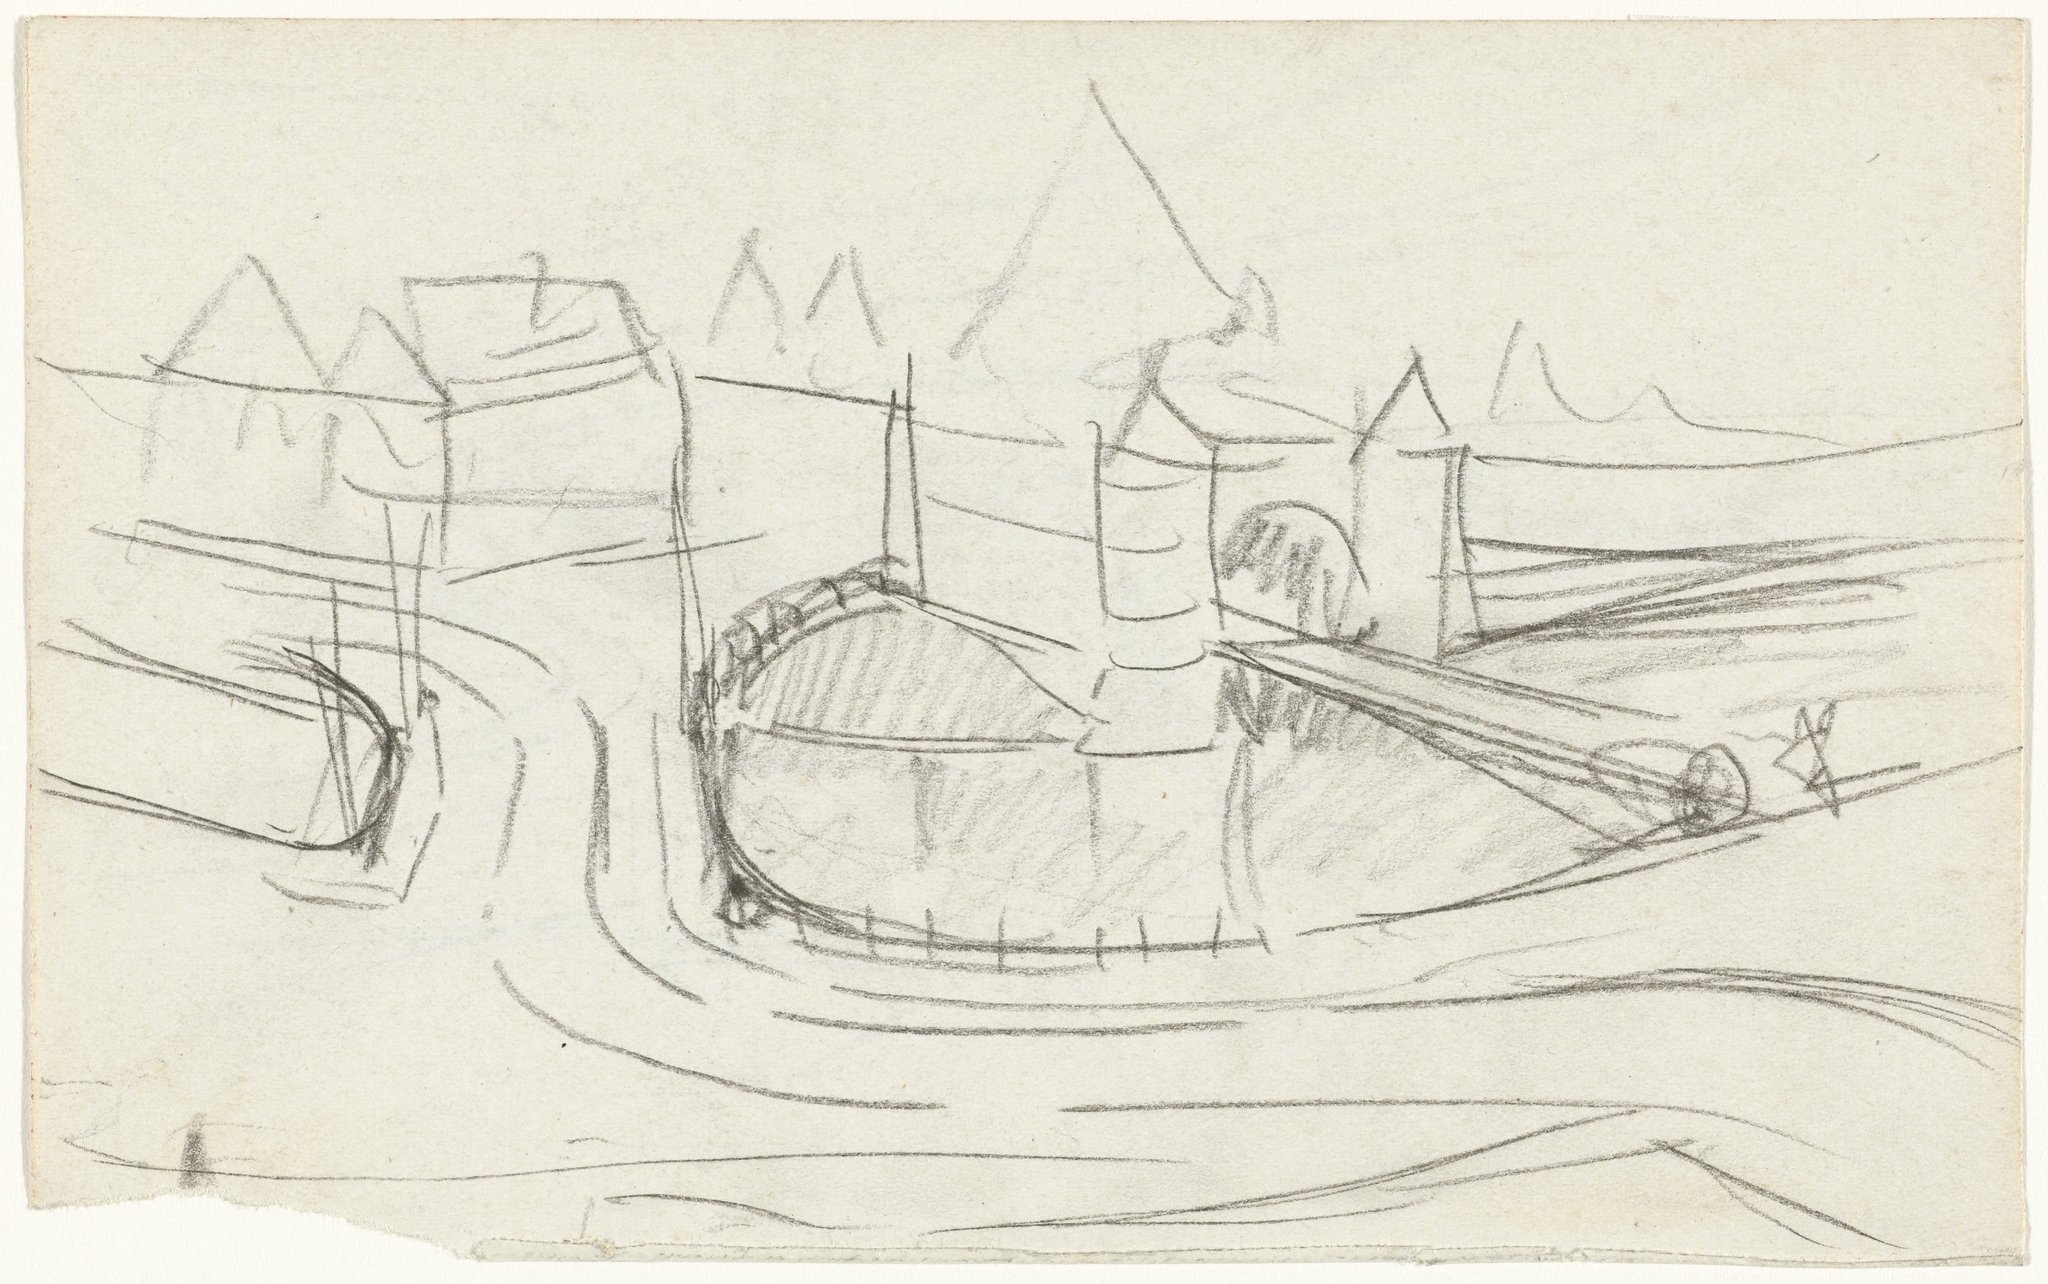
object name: drawing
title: De Amsterdamse Poort te Haarlem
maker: gerrit willem dijsselhof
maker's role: designer, draughtsman, print maker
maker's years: 1866-1924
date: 1876-1924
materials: chalk, paper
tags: city-gate, haarlem